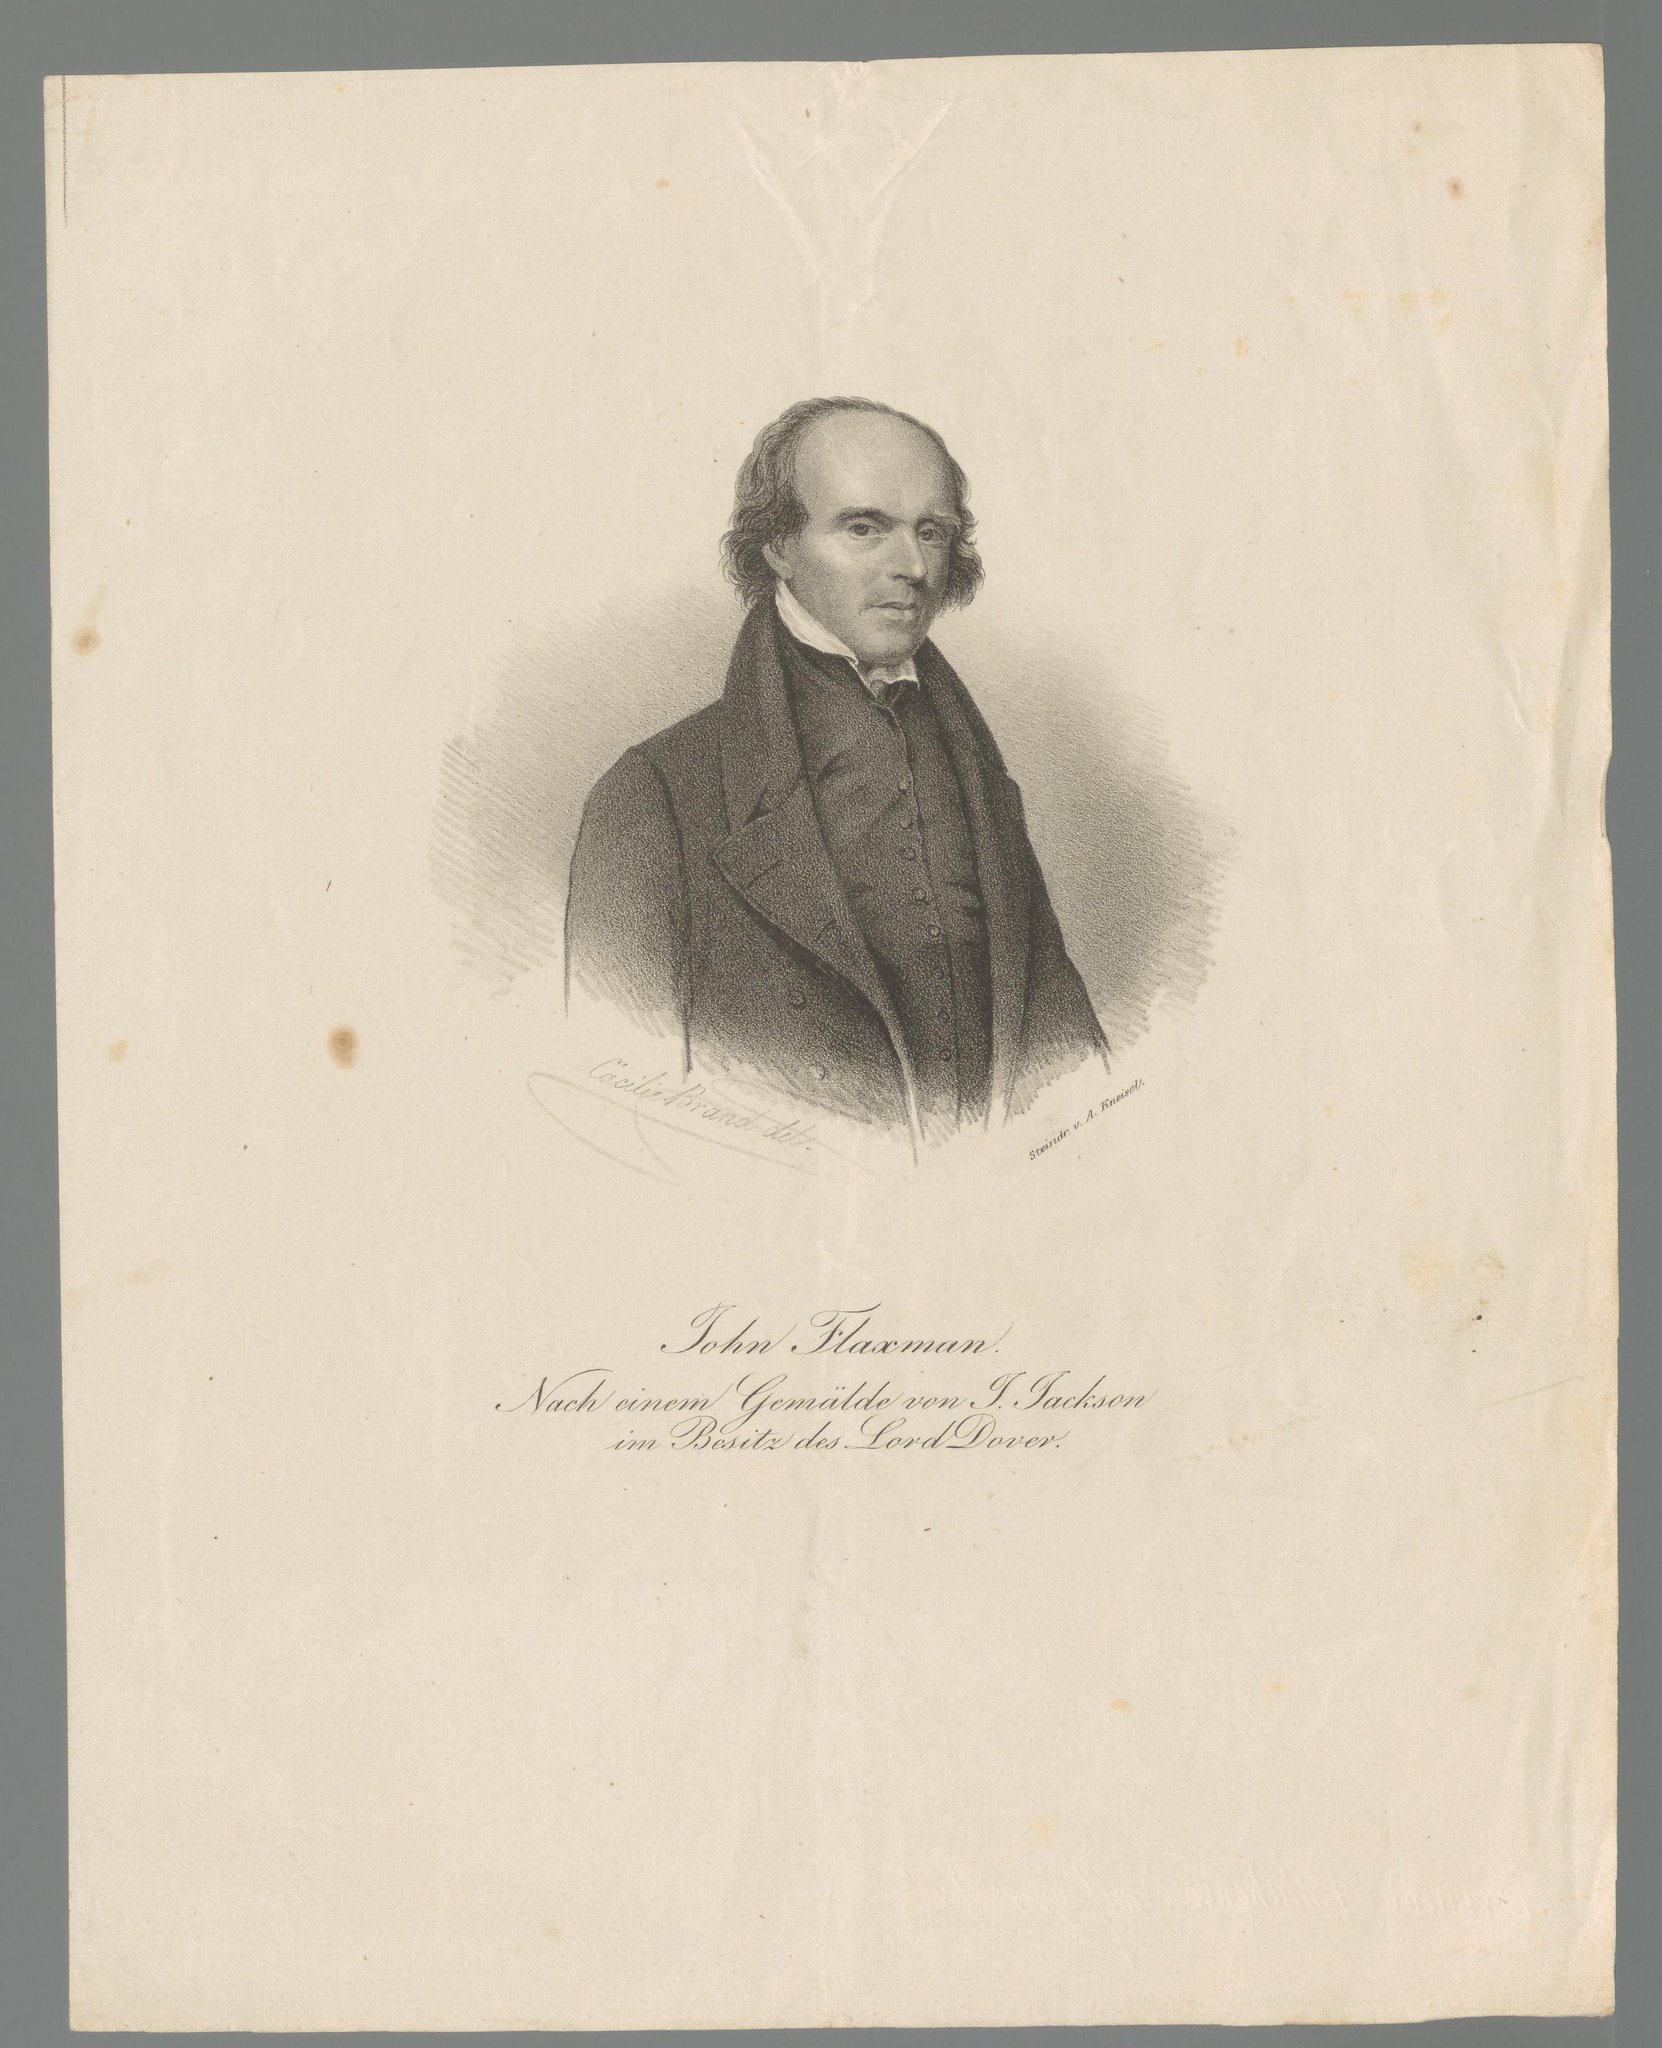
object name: print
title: Portret van John Flaxman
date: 1825-1850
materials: paper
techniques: lithograph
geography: leipzig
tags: adult man, historical persons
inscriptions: collector's mark: Lugt 2228